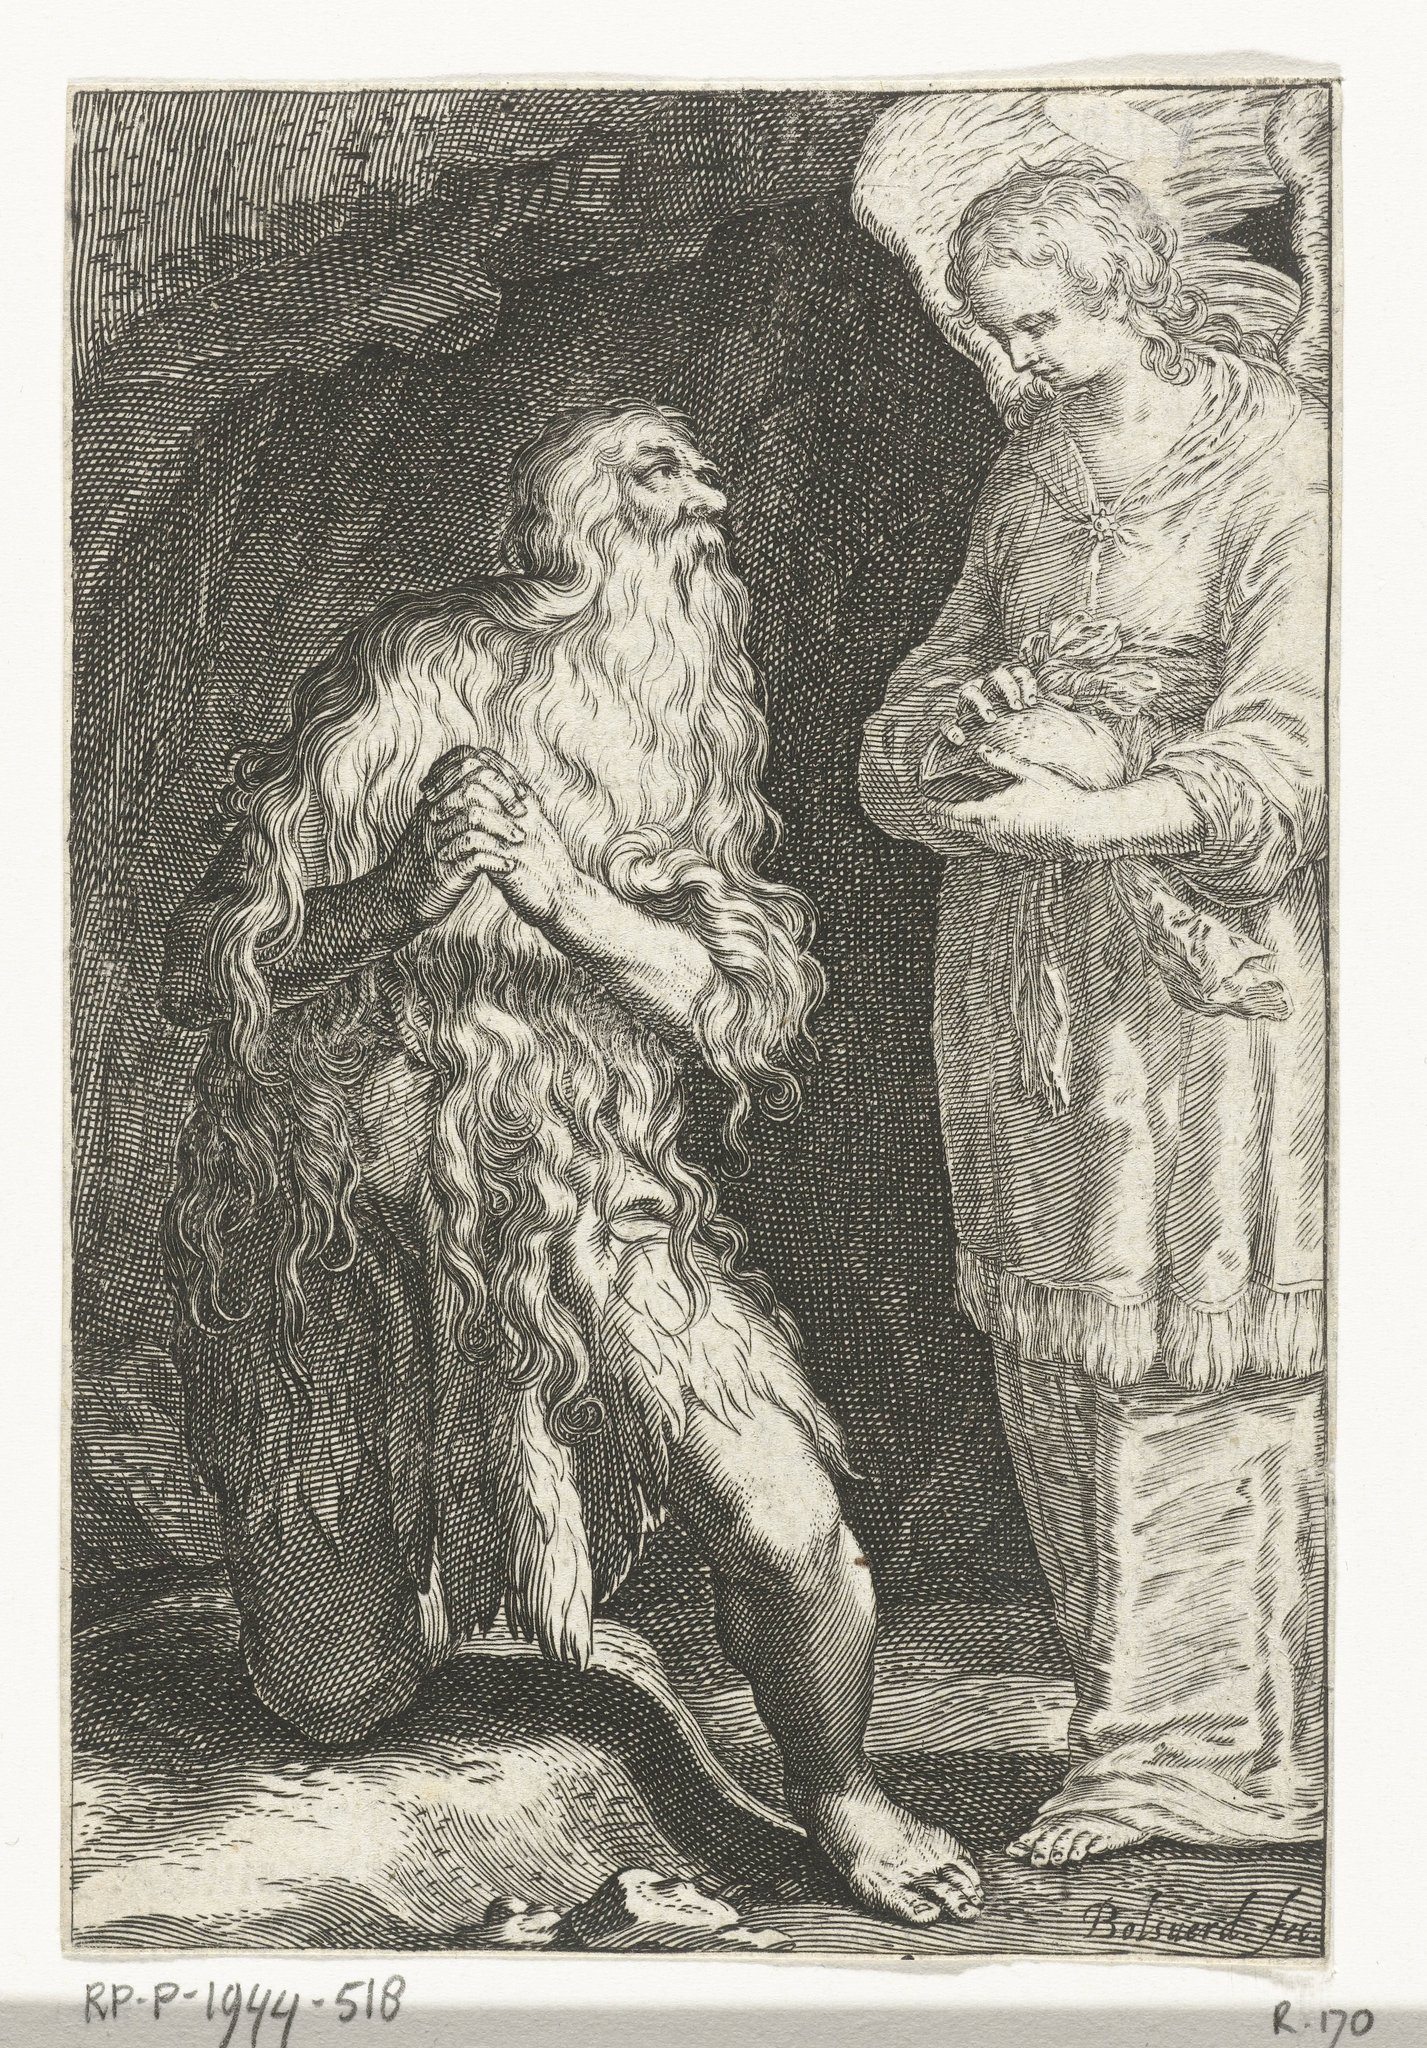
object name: book illustration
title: Sacra eremvs ascetarvm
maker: boëtius adamsz. bolswert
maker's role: print maker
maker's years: 1580-1633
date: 1590-1612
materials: paper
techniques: engraving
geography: amsterdam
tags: male saints (with name)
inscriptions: collector's mark: Lugt 2228, collector's mark: Lugt 240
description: Prent uit: Sacra eremus ascetarum, geen plaats, Boëtius Adamsz. Bolswert, 1619. Eerste gebonden uitgave met in totaal vijftig prenten. Prent uit serie van vijfentwintig mannelijke kluizenaars. In 1612 verscheen een ongebonden editie maar op basis van de gewijzigde opschriften en samenstelling wordt aangenomen dat de prenten van de uitgave 1619 ook in 1612 of iets daarvoor gedrukt werden. Roethlisberger beschouwt de uitgave van 1619 als de eerste staat en de ongebonden editie van 1612 als de tweede staat (Roethlisberger 1993, p. 171, 172). Deze prent verscheen alleen in de uitgave van 1619.